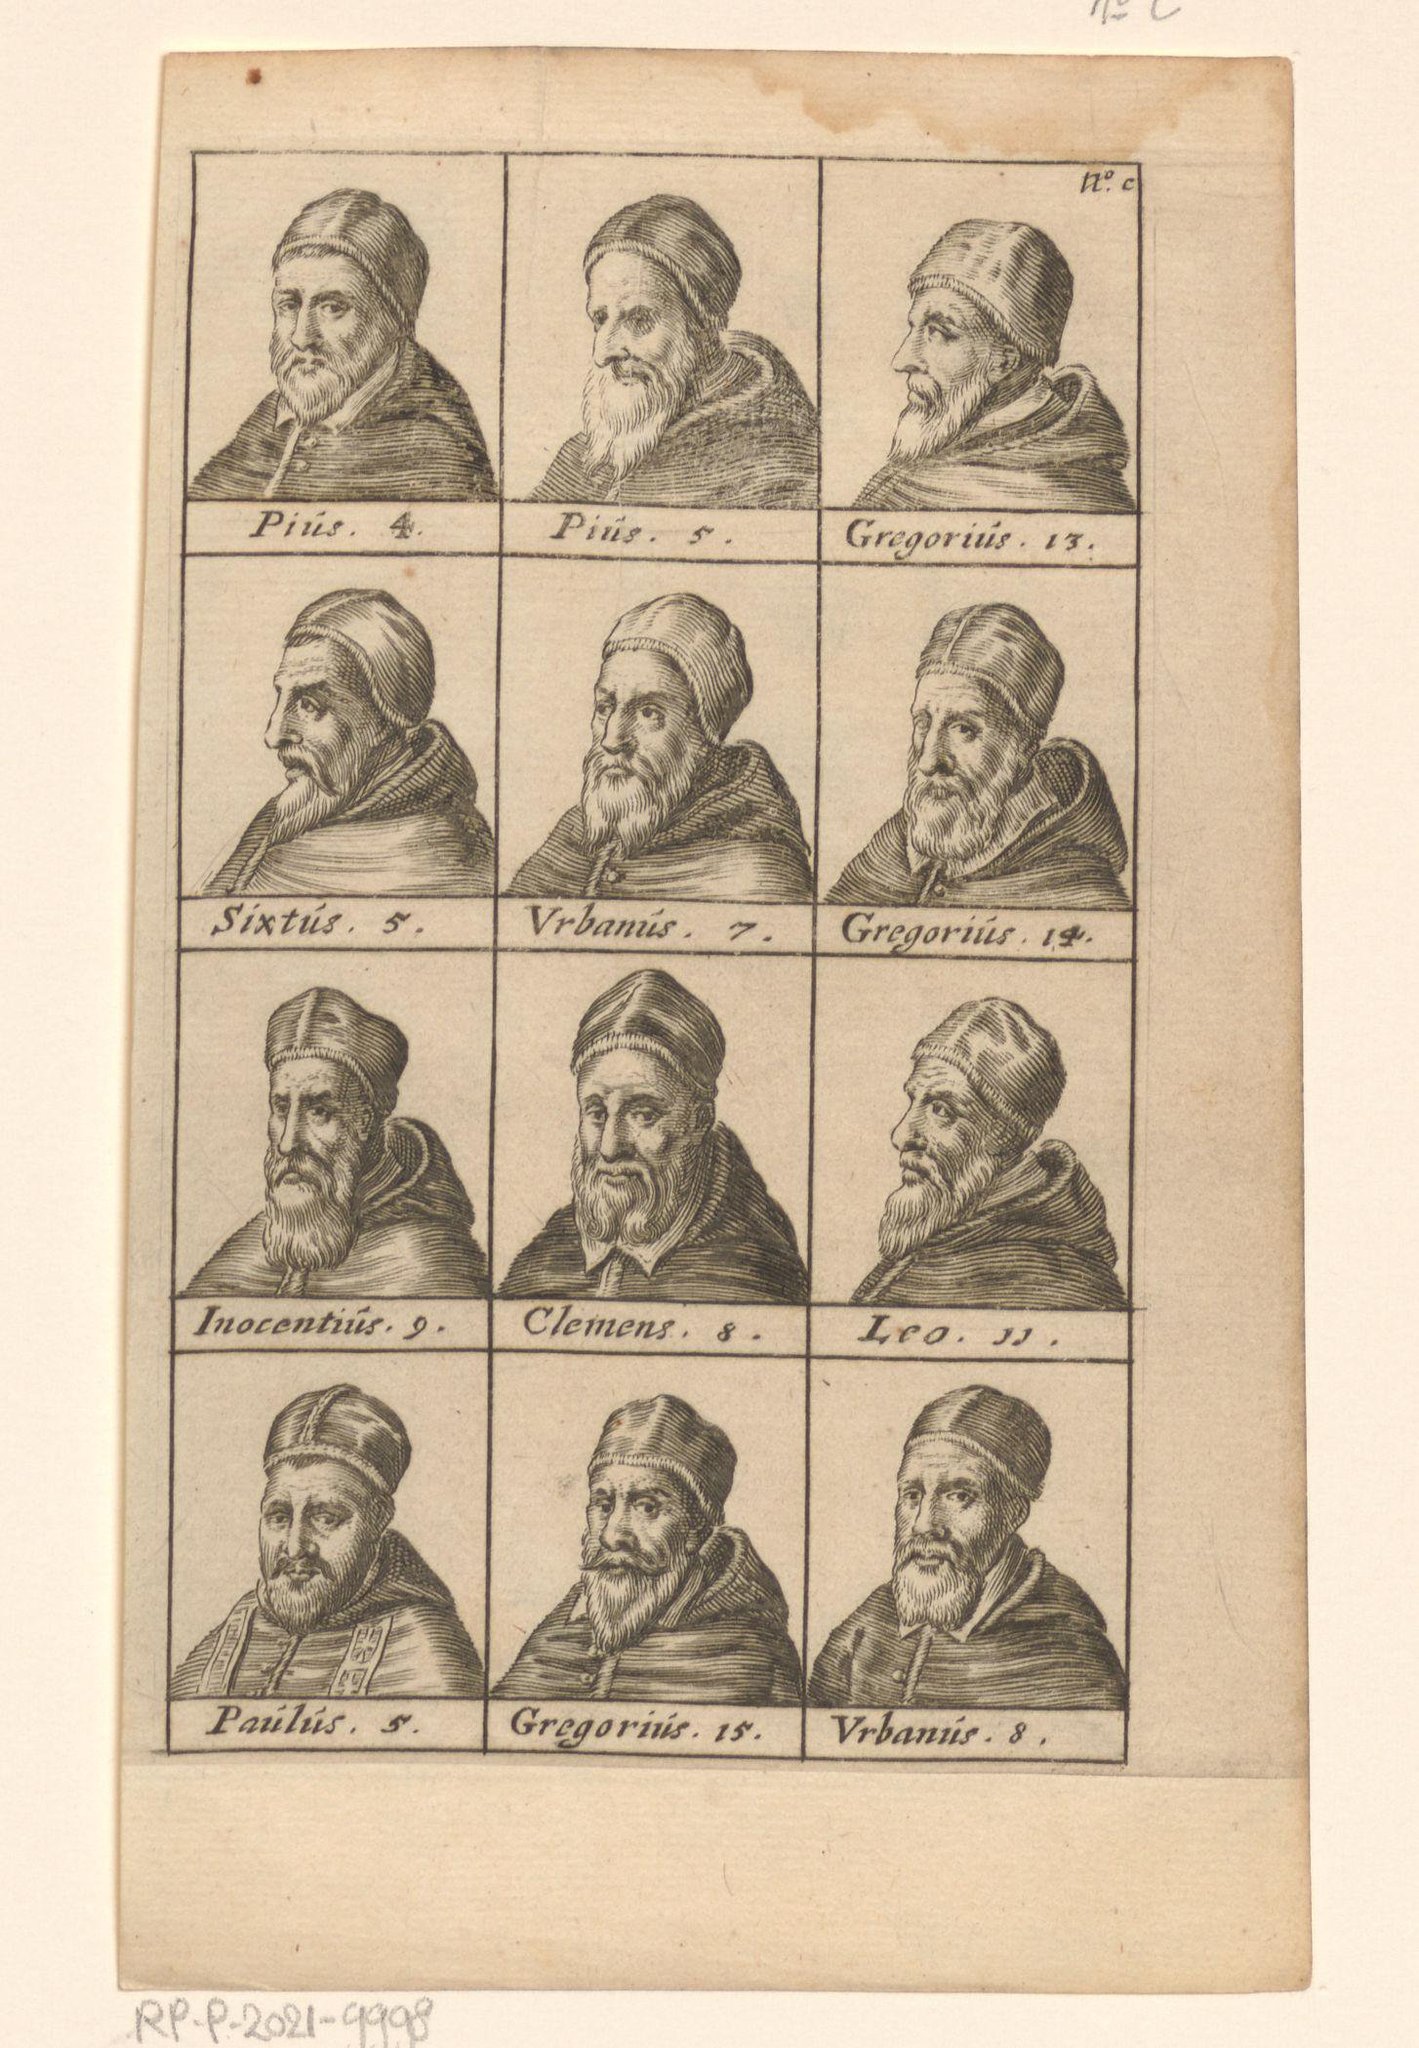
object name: print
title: Portretten van twaalf pausen van Pius IV tot en met Urbanus VIII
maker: Anonymous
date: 1650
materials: paper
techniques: engraving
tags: pius v, sixtus v, clergyman, urbanus viii, paulus v, leo xi, gregorius xiv, pius iv, gregorius xv, gregorius xiii, clemens viii, historical persons, pope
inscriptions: collector's mark: Lugt 2228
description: Rechtsboven genummerd: No. c. Portretten van de pausen Pius IV, Pius V, Gregorius XIII, Sixtus V, Urbanus VII, Gregorius XIV, Innocentius IX, Clemens VIII, Leo XI, Paulus V, Gregorius XV en Urbanus VIII.